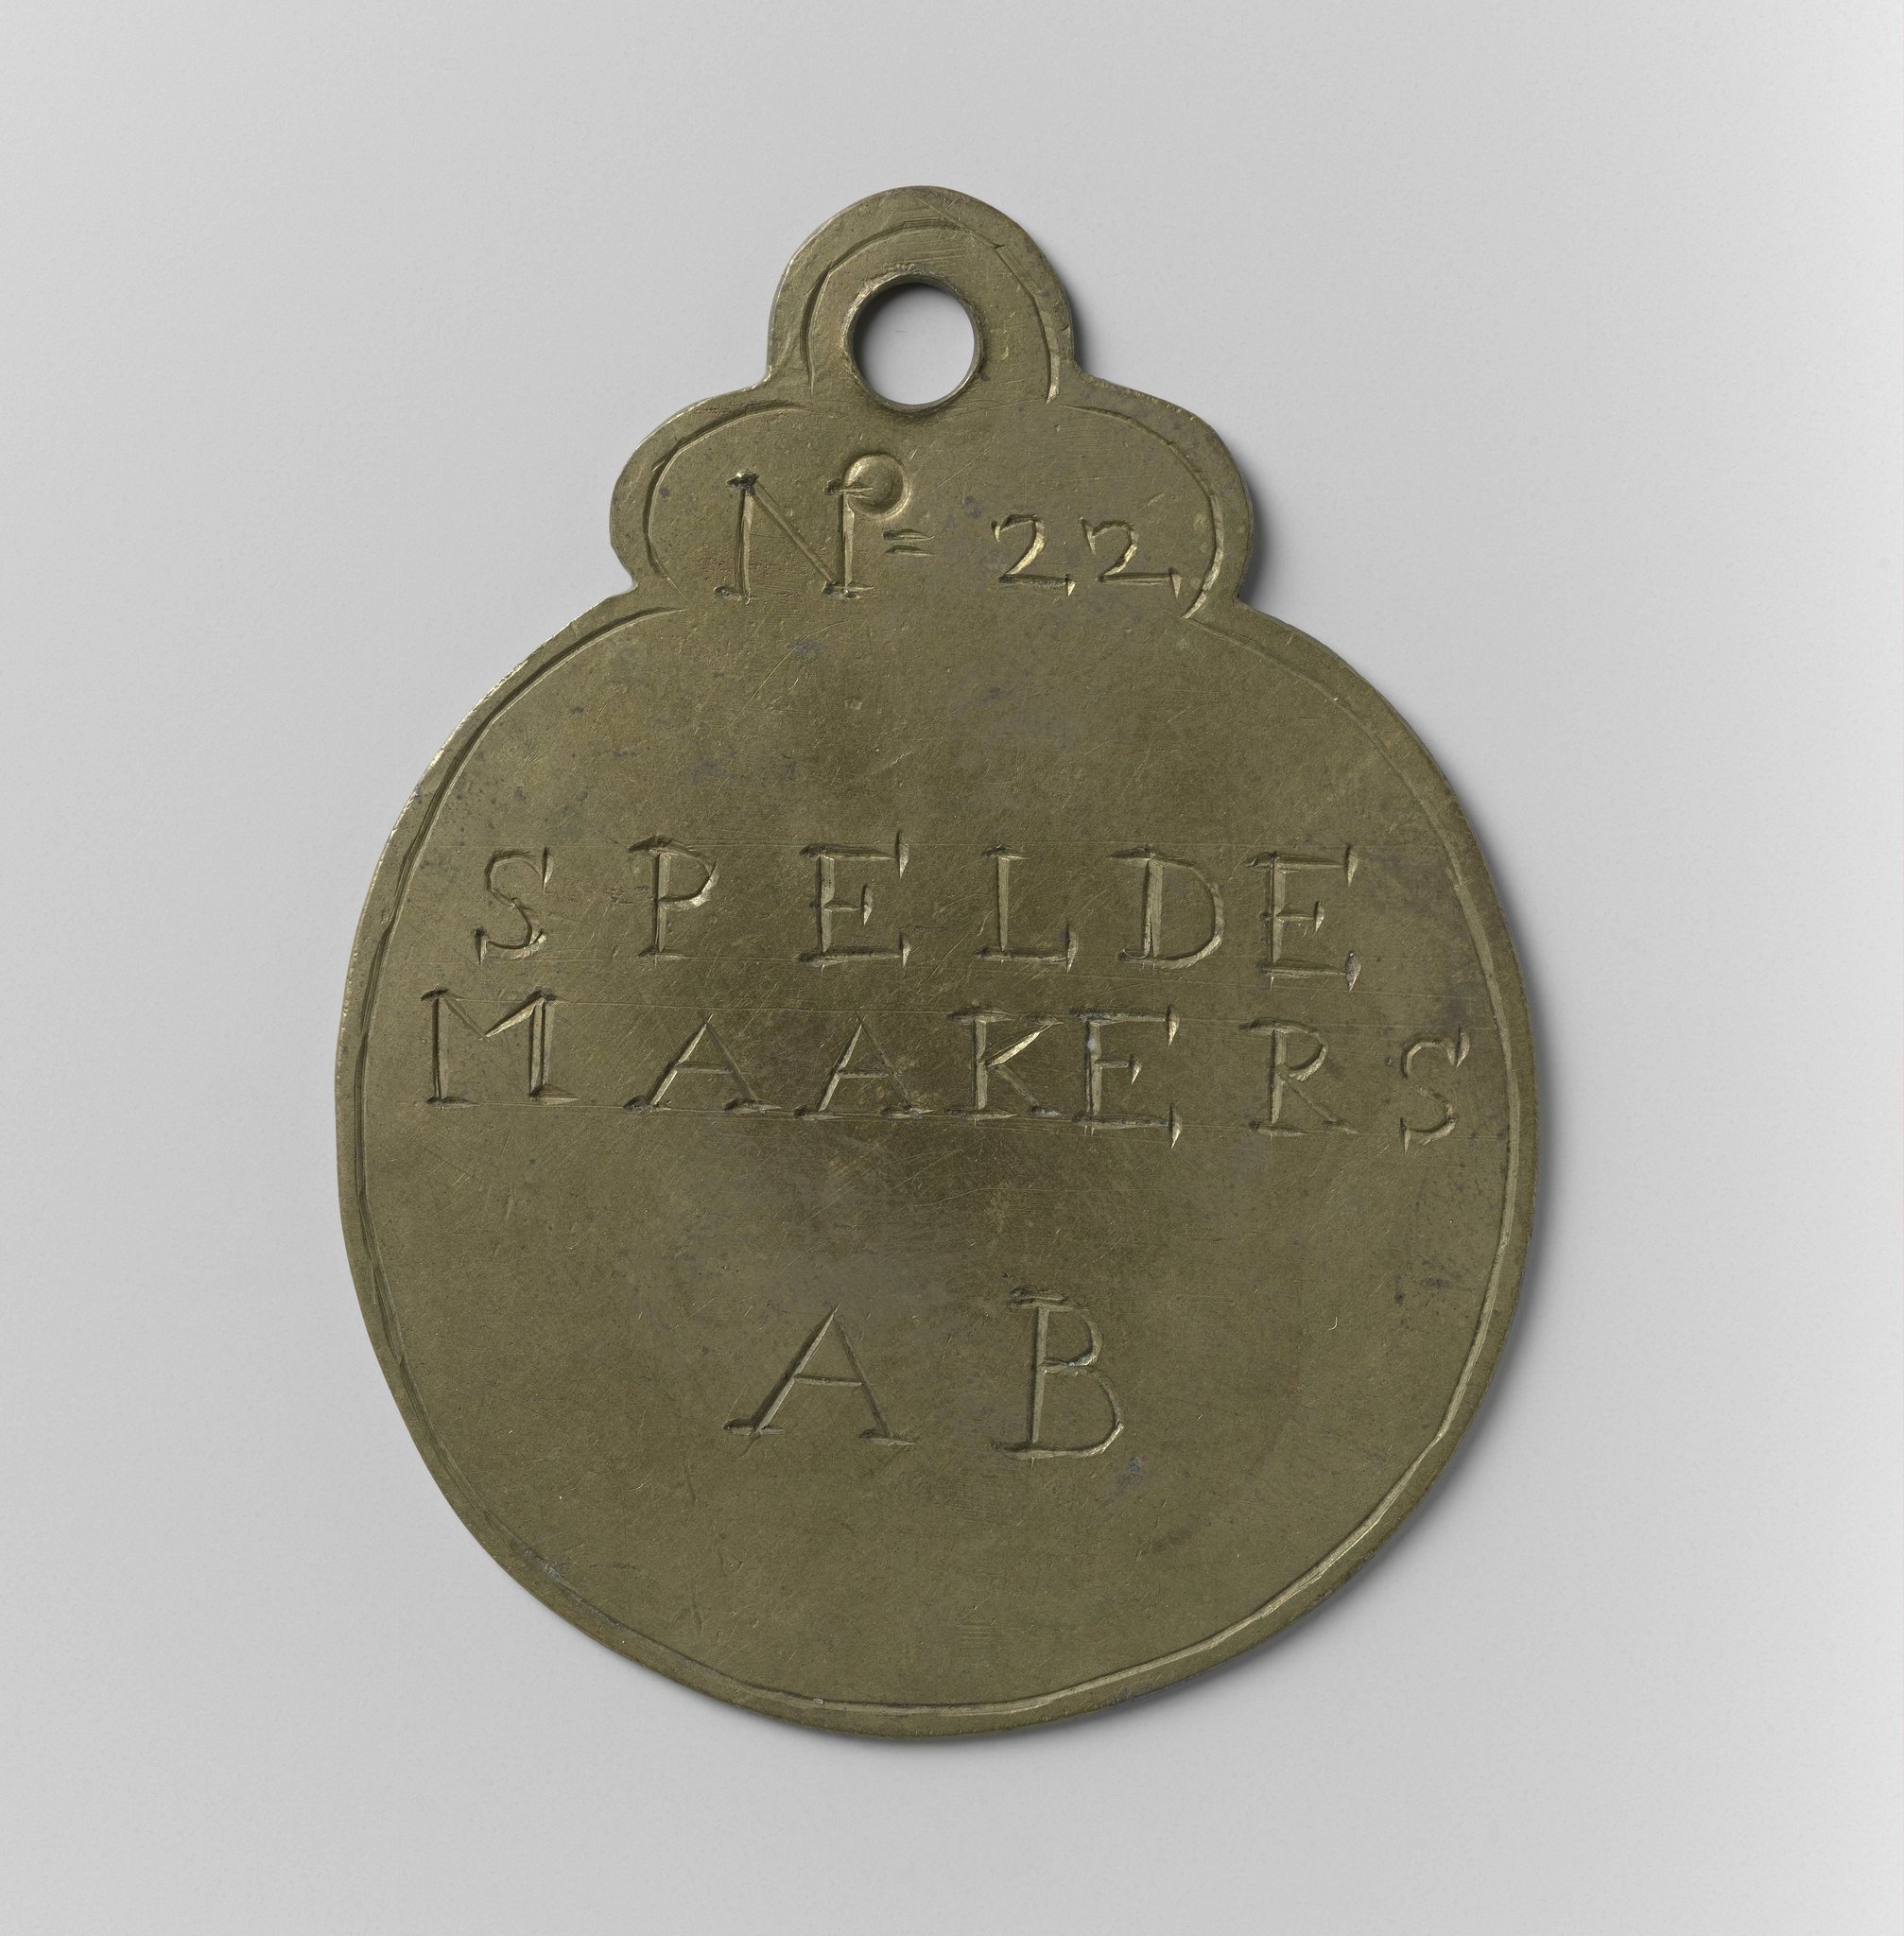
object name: medal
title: Speldenmakersgilde van 's-Hertogenbosch, gildepenning met no. 22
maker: Anonymous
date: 1600-1800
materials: brass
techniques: engraving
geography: den bosch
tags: den bosch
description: Messing penning aan draagoog. Voorzijde: St. Thomas, blootsvoets met lans in rechterhand en boek onder linkerarm. Keerzijde: opschrift; onder draagoog: cijfer No. 22